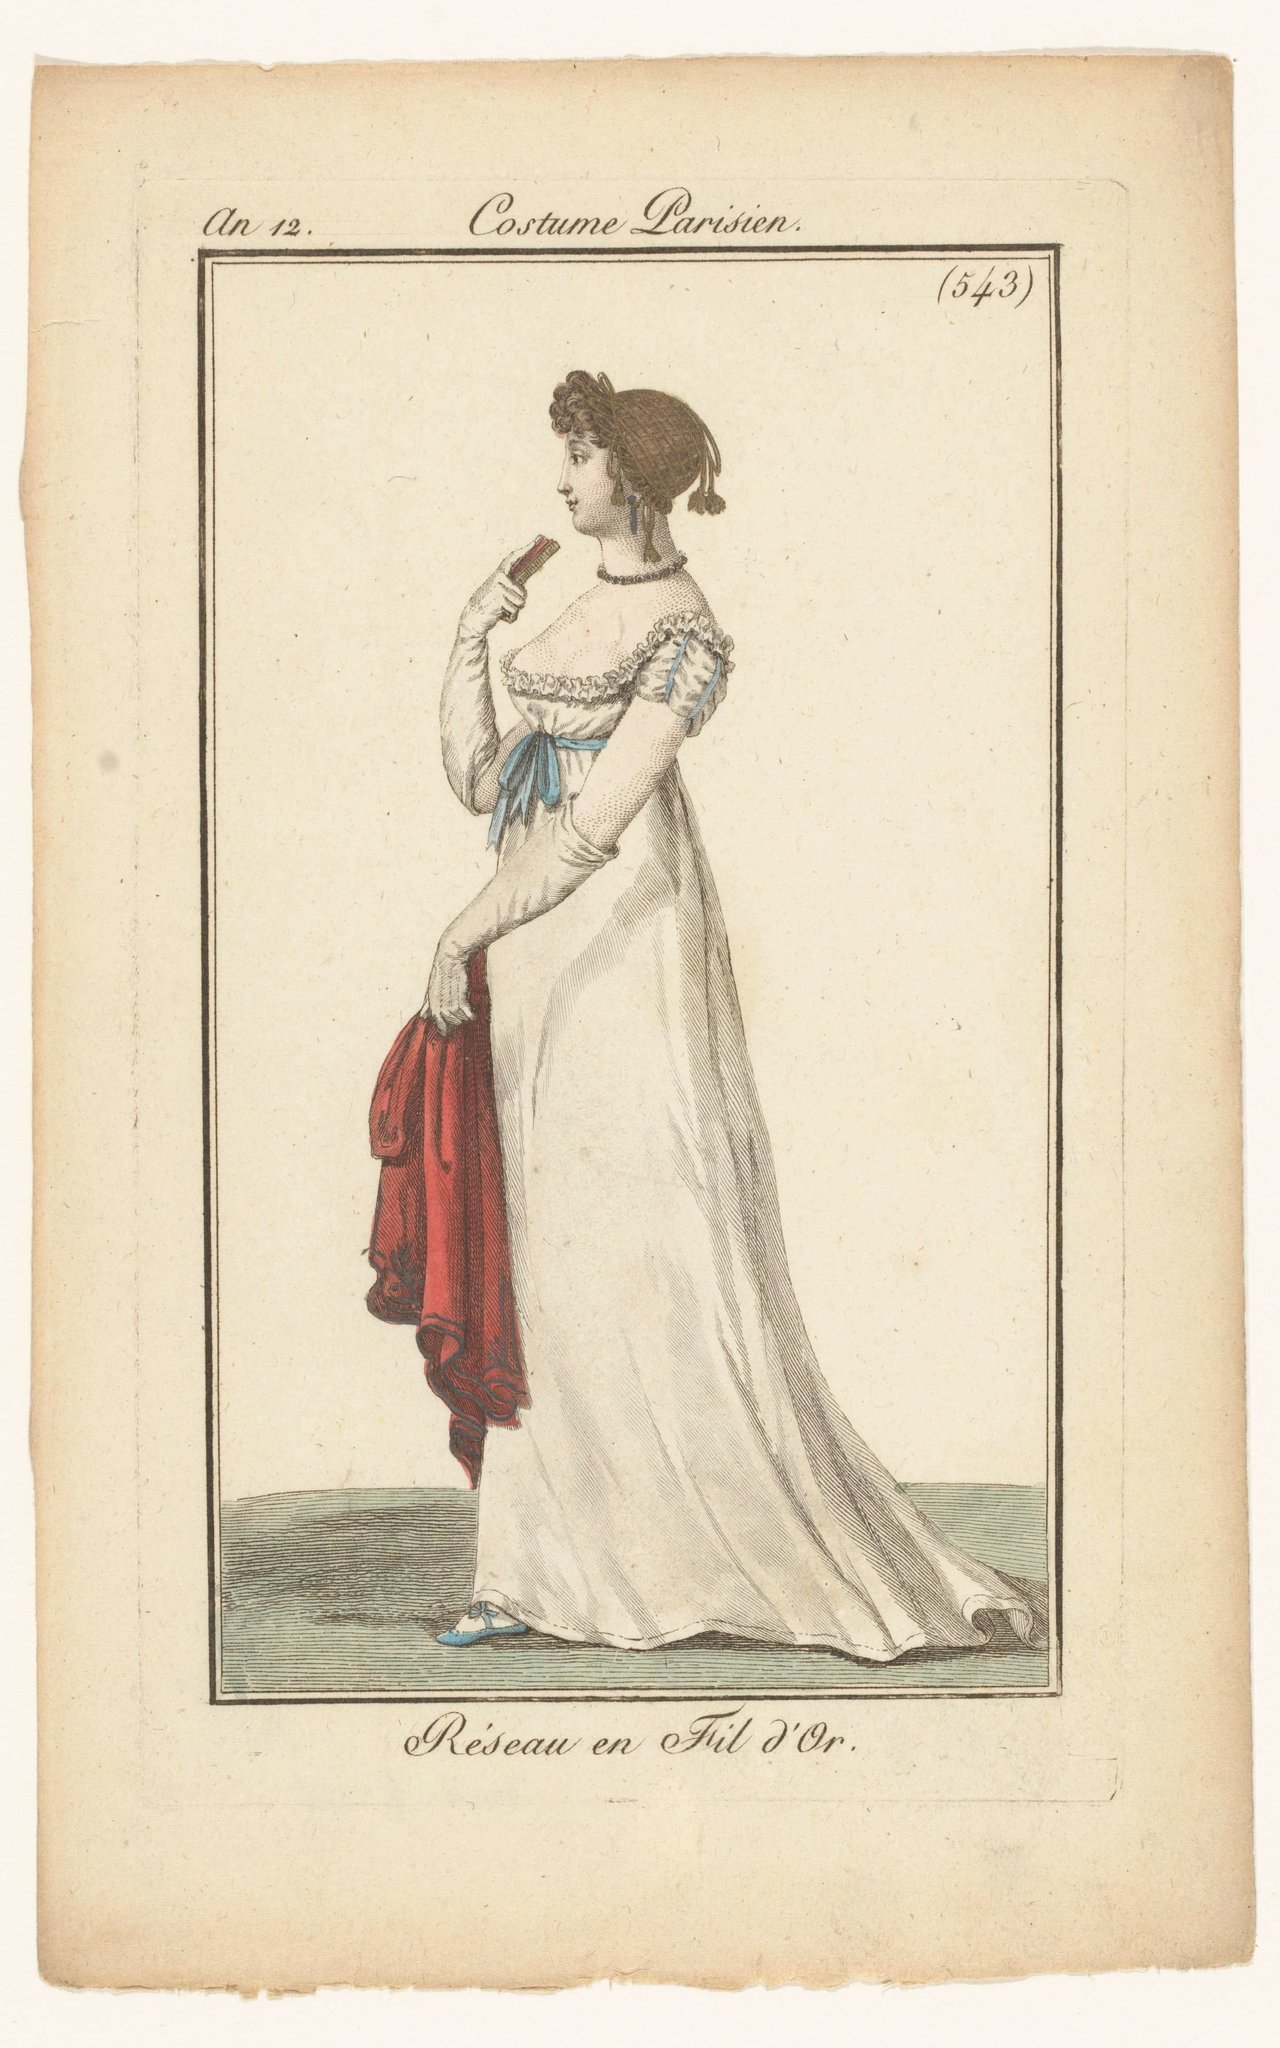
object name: fashion print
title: Journal des Dames et des modes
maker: Anonymous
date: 1803-1804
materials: paper, ink, watercolor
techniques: etching, hand coloring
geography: france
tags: fashion plates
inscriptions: collector's mark: Lugt 2228